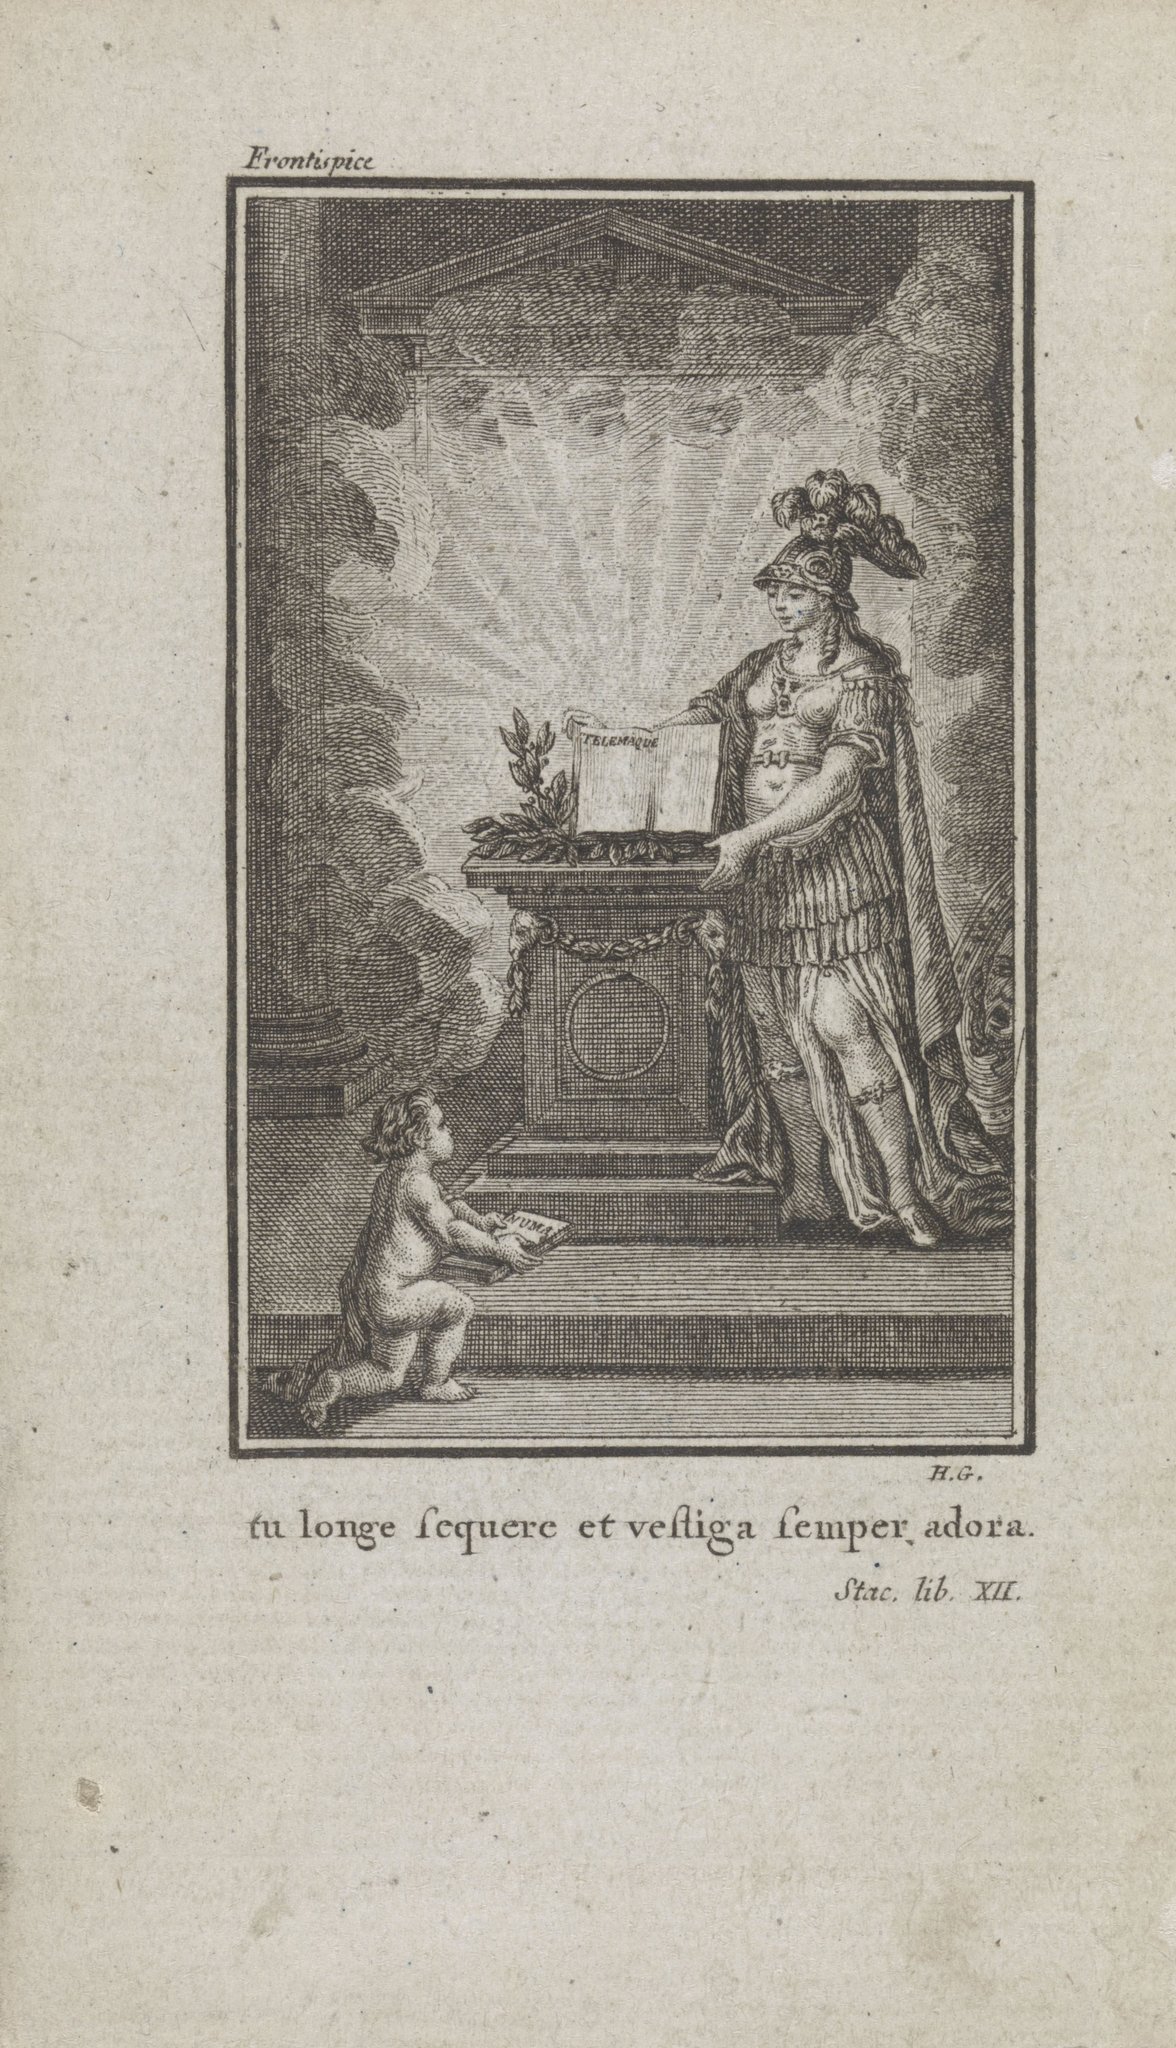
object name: titelblad, titelpagina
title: Minerva presenteert het boek Telemaque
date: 1790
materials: paper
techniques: engraving, letterpress printing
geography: brussels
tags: (story of) minerva (pallas, athena), cupids: 'amores', 'amoretti', 'putti'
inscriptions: collector's mark: Lugt 2228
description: Minerva staat in volle wapenrusting naast een voetstuk. Ze presenteert een open boek met daarin geschreven: Télémaque. Een putto knielt voor het voetstuk. Hij heeft een open boek vast met daarin geschreven: Numa. Met een Frans onderschrift.